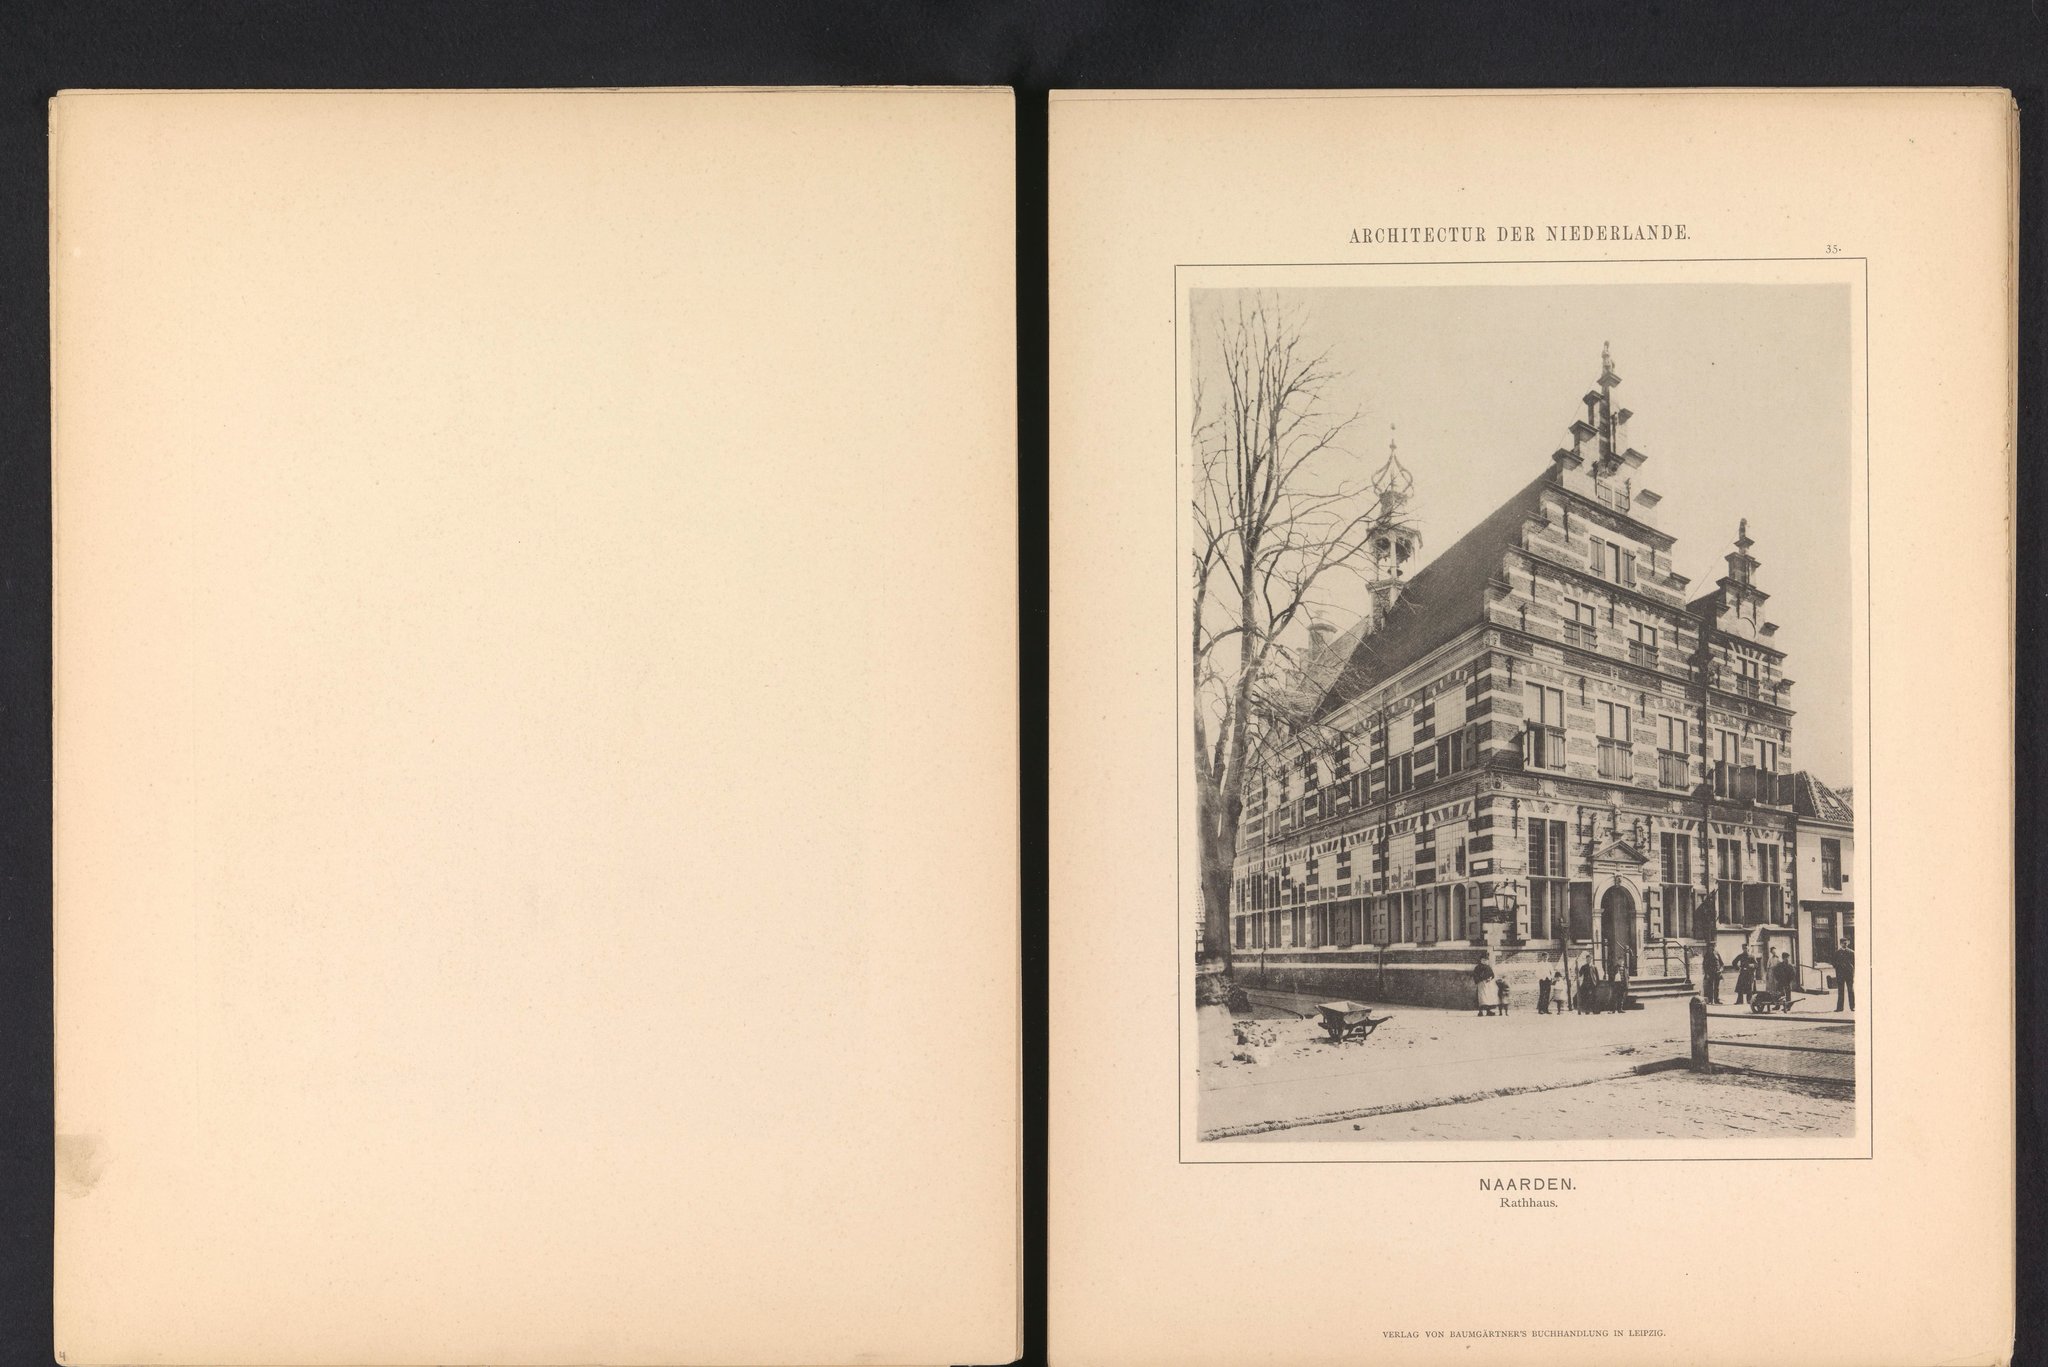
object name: photomechanical print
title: Gezicht op het stadhuis in Naarden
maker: Anonymous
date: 1884-1894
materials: paper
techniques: photograph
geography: leipzig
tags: townhall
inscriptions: number: ‘35.’